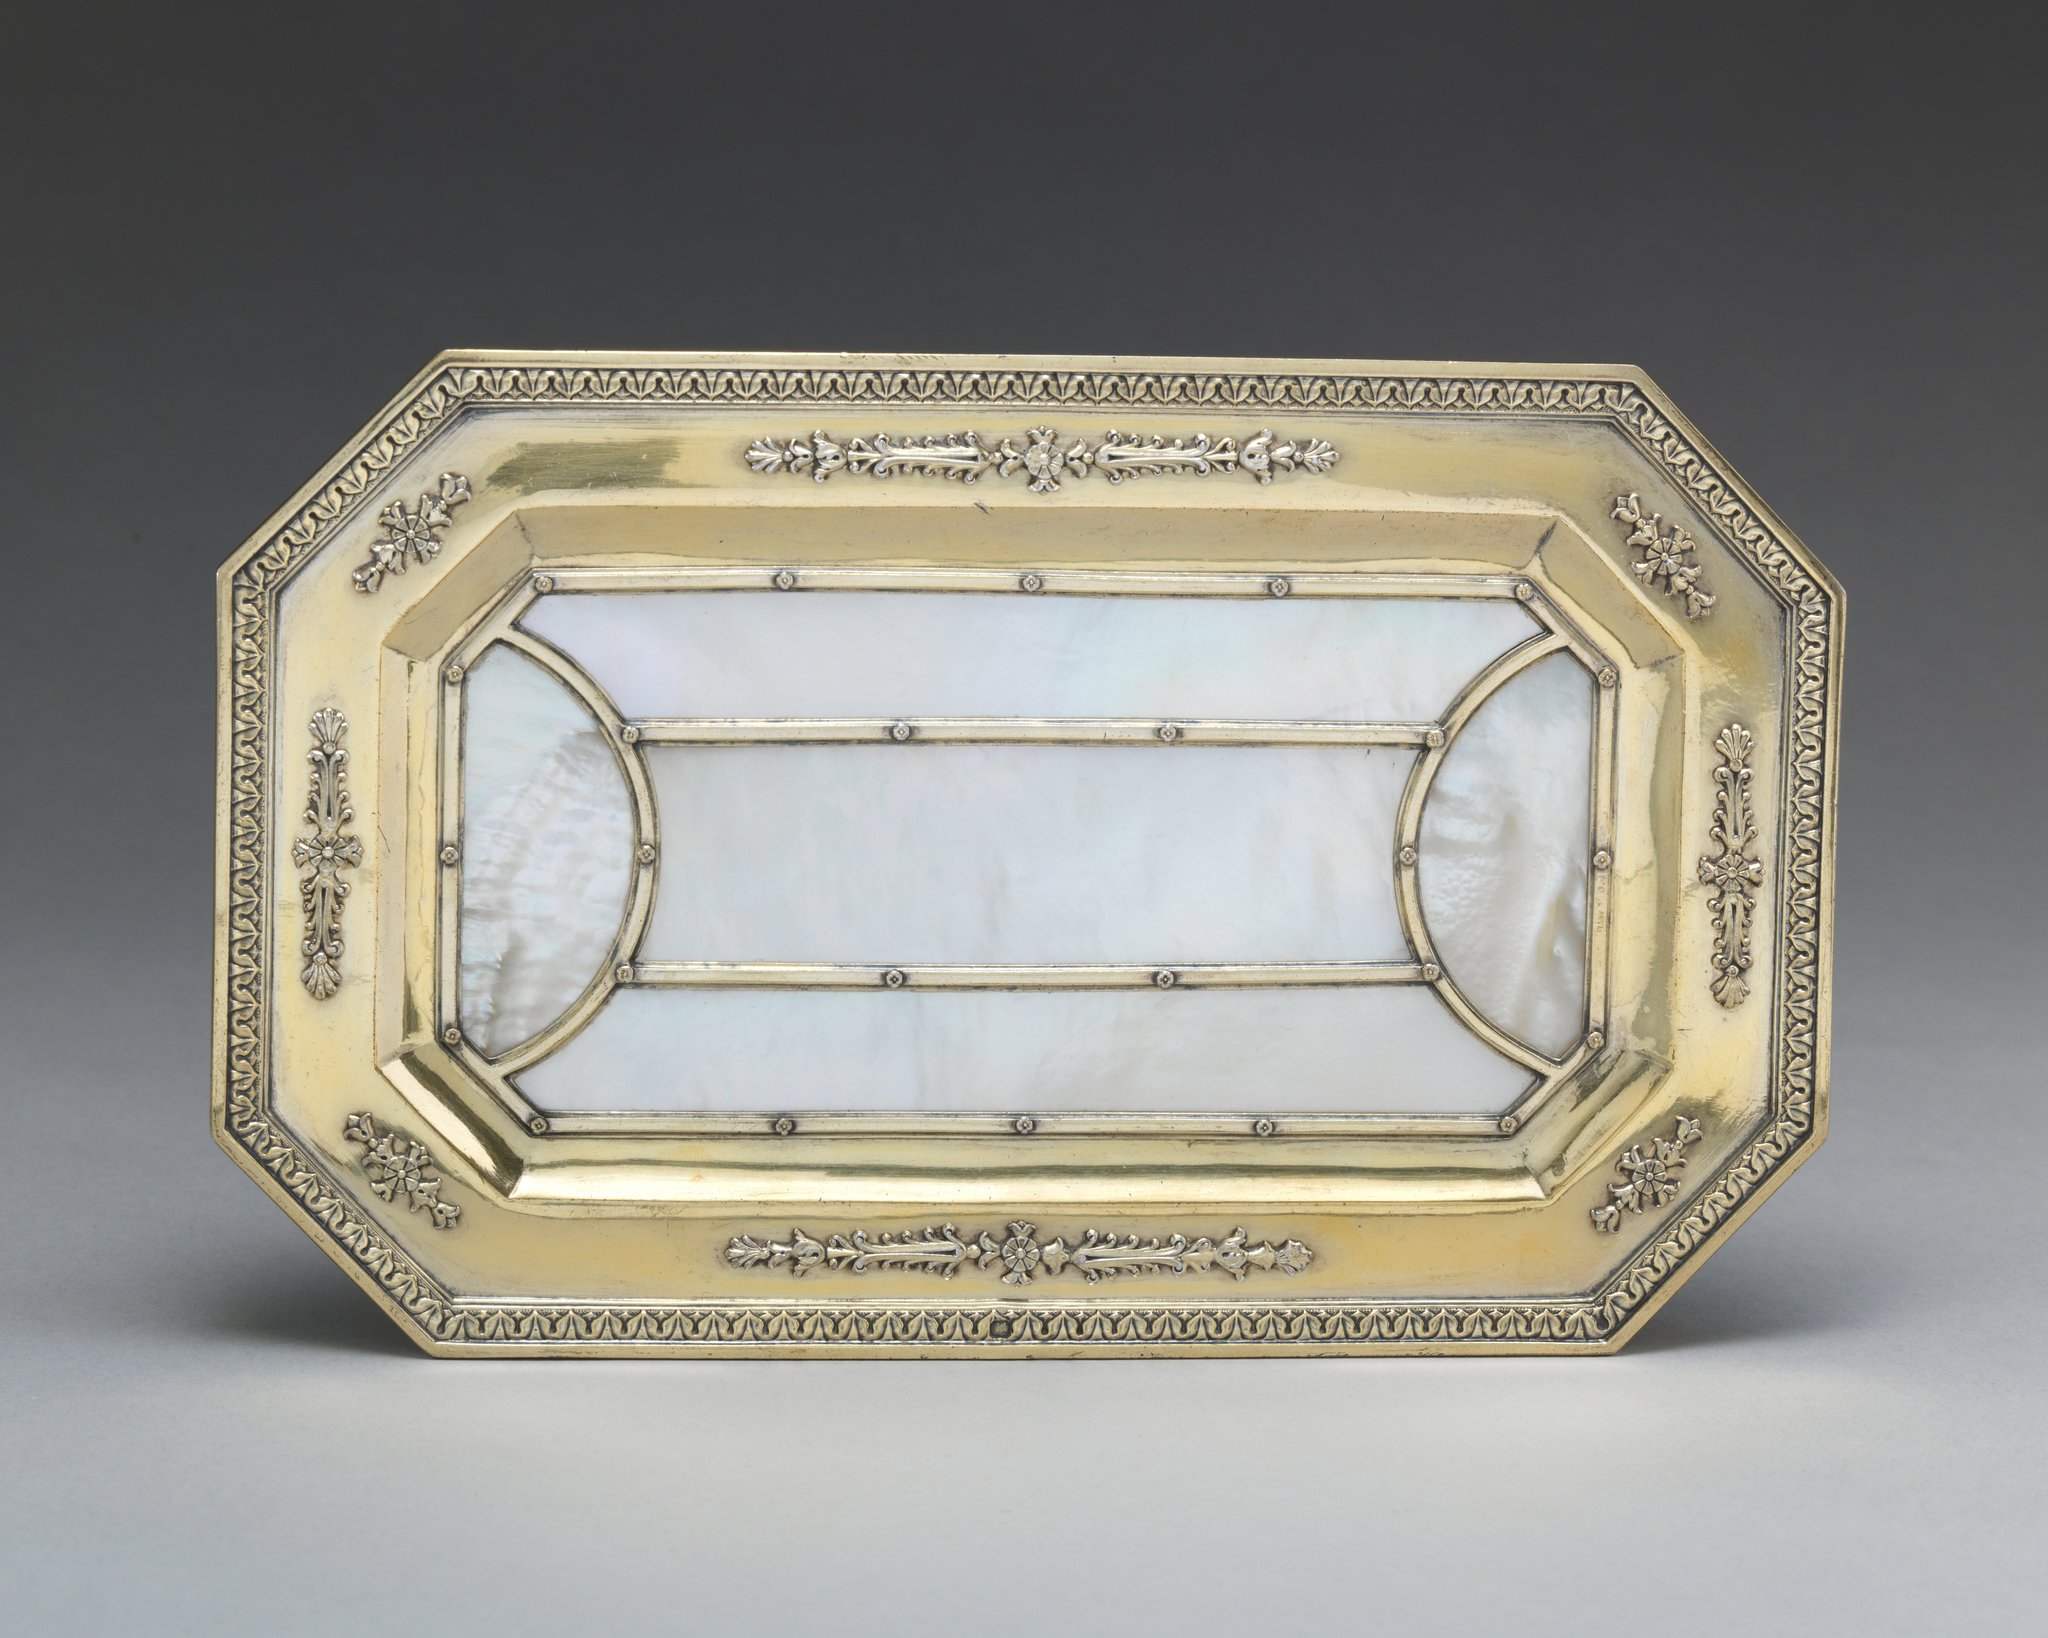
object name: tray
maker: andré aucoc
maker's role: maker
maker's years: 1825-1925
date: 1887-1911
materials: mother of pearl, silver gilt